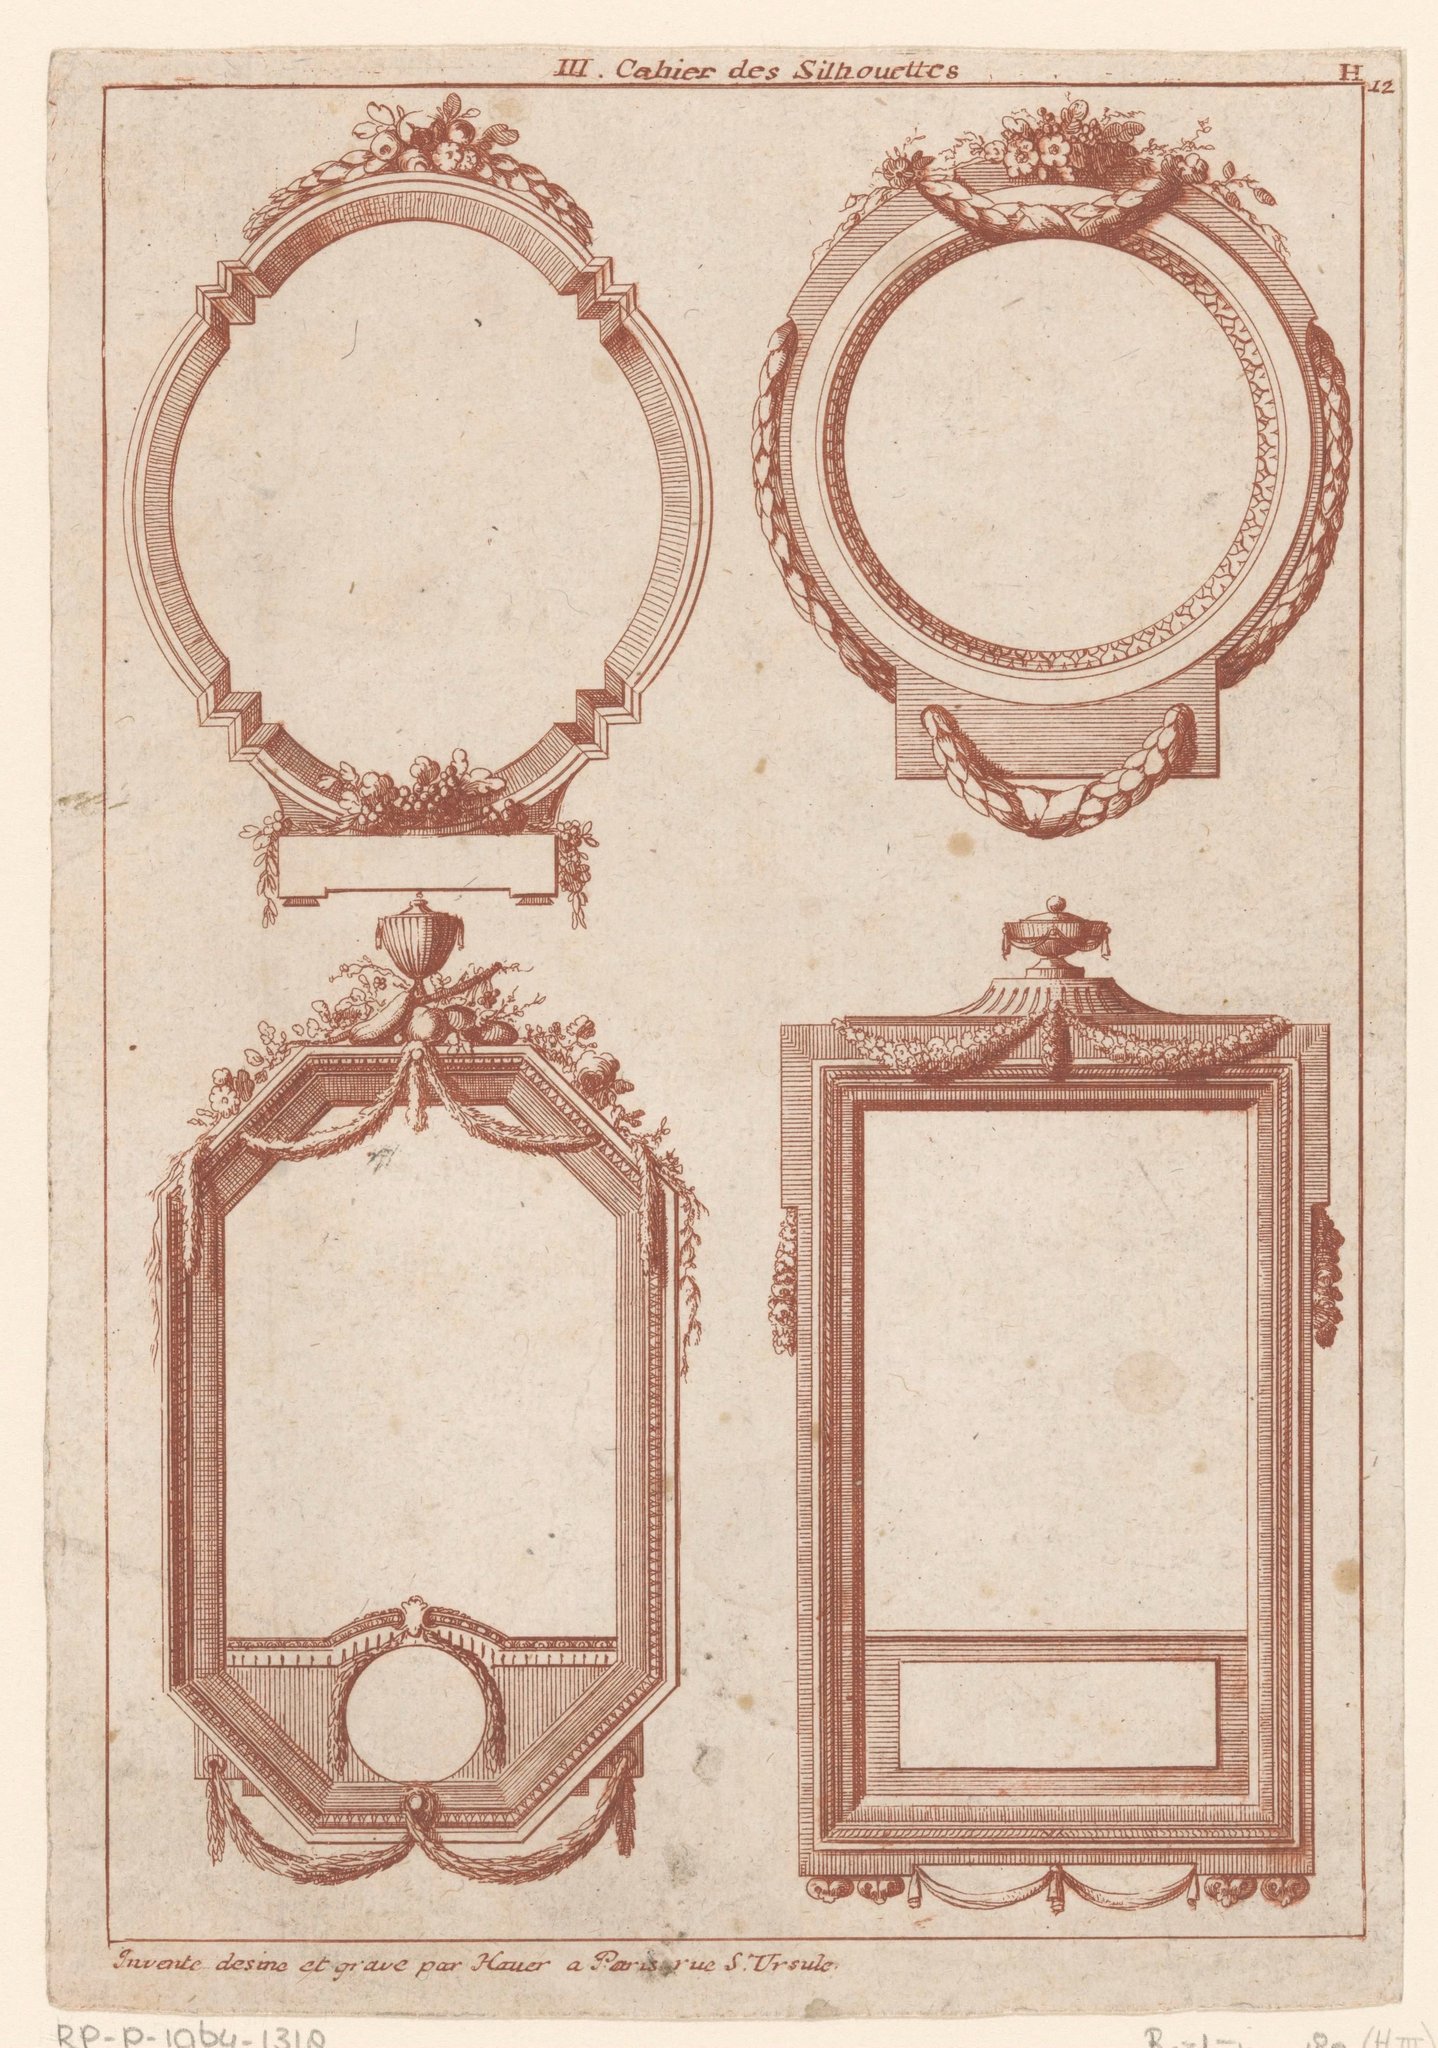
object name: ornament print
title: Omlijstingen met vazen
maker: johann thomas hauer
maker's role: print maker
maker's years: 1748-1820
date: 1781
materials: paper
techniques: engraving, etching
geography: paris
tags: ornaments ~ art (+ framing decorations)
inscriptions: collector's mark: Lugt 2760, collector's mark: Lugt 2228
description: Vier omlijstingen met fruit, bloemen, guirlandes en vazen.